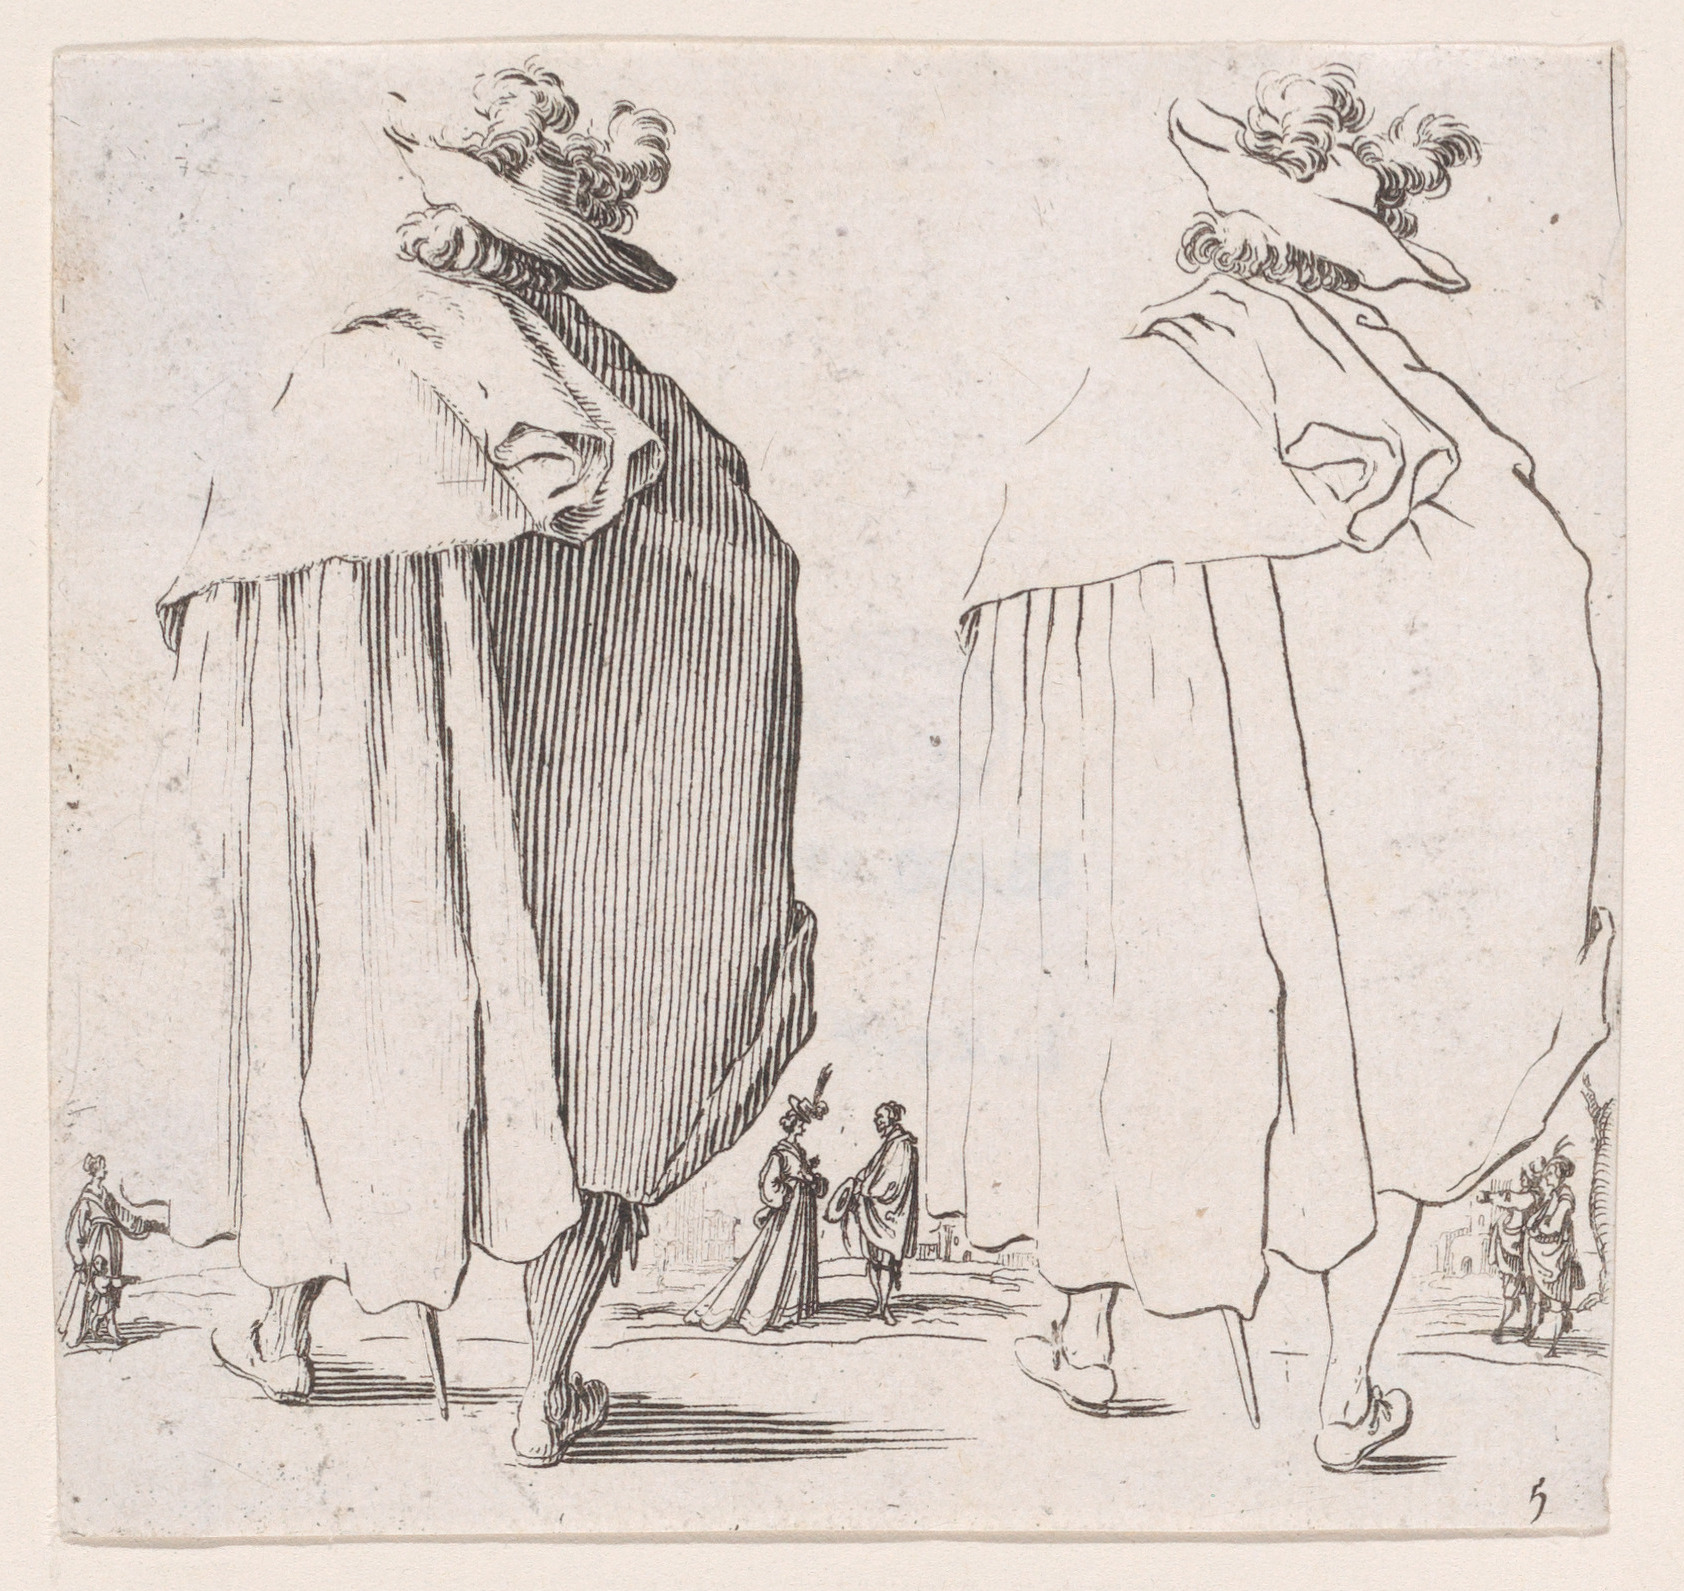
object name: print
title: L'Homme au Grand Manteau Vu de Dos (Man with a Large Mantle Viewed from Behind), plate 5 from "Varie Figure" (Various Figures)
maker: jacques callot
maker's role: artist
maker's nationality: french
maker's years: 1592-1635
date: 1620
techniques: etching